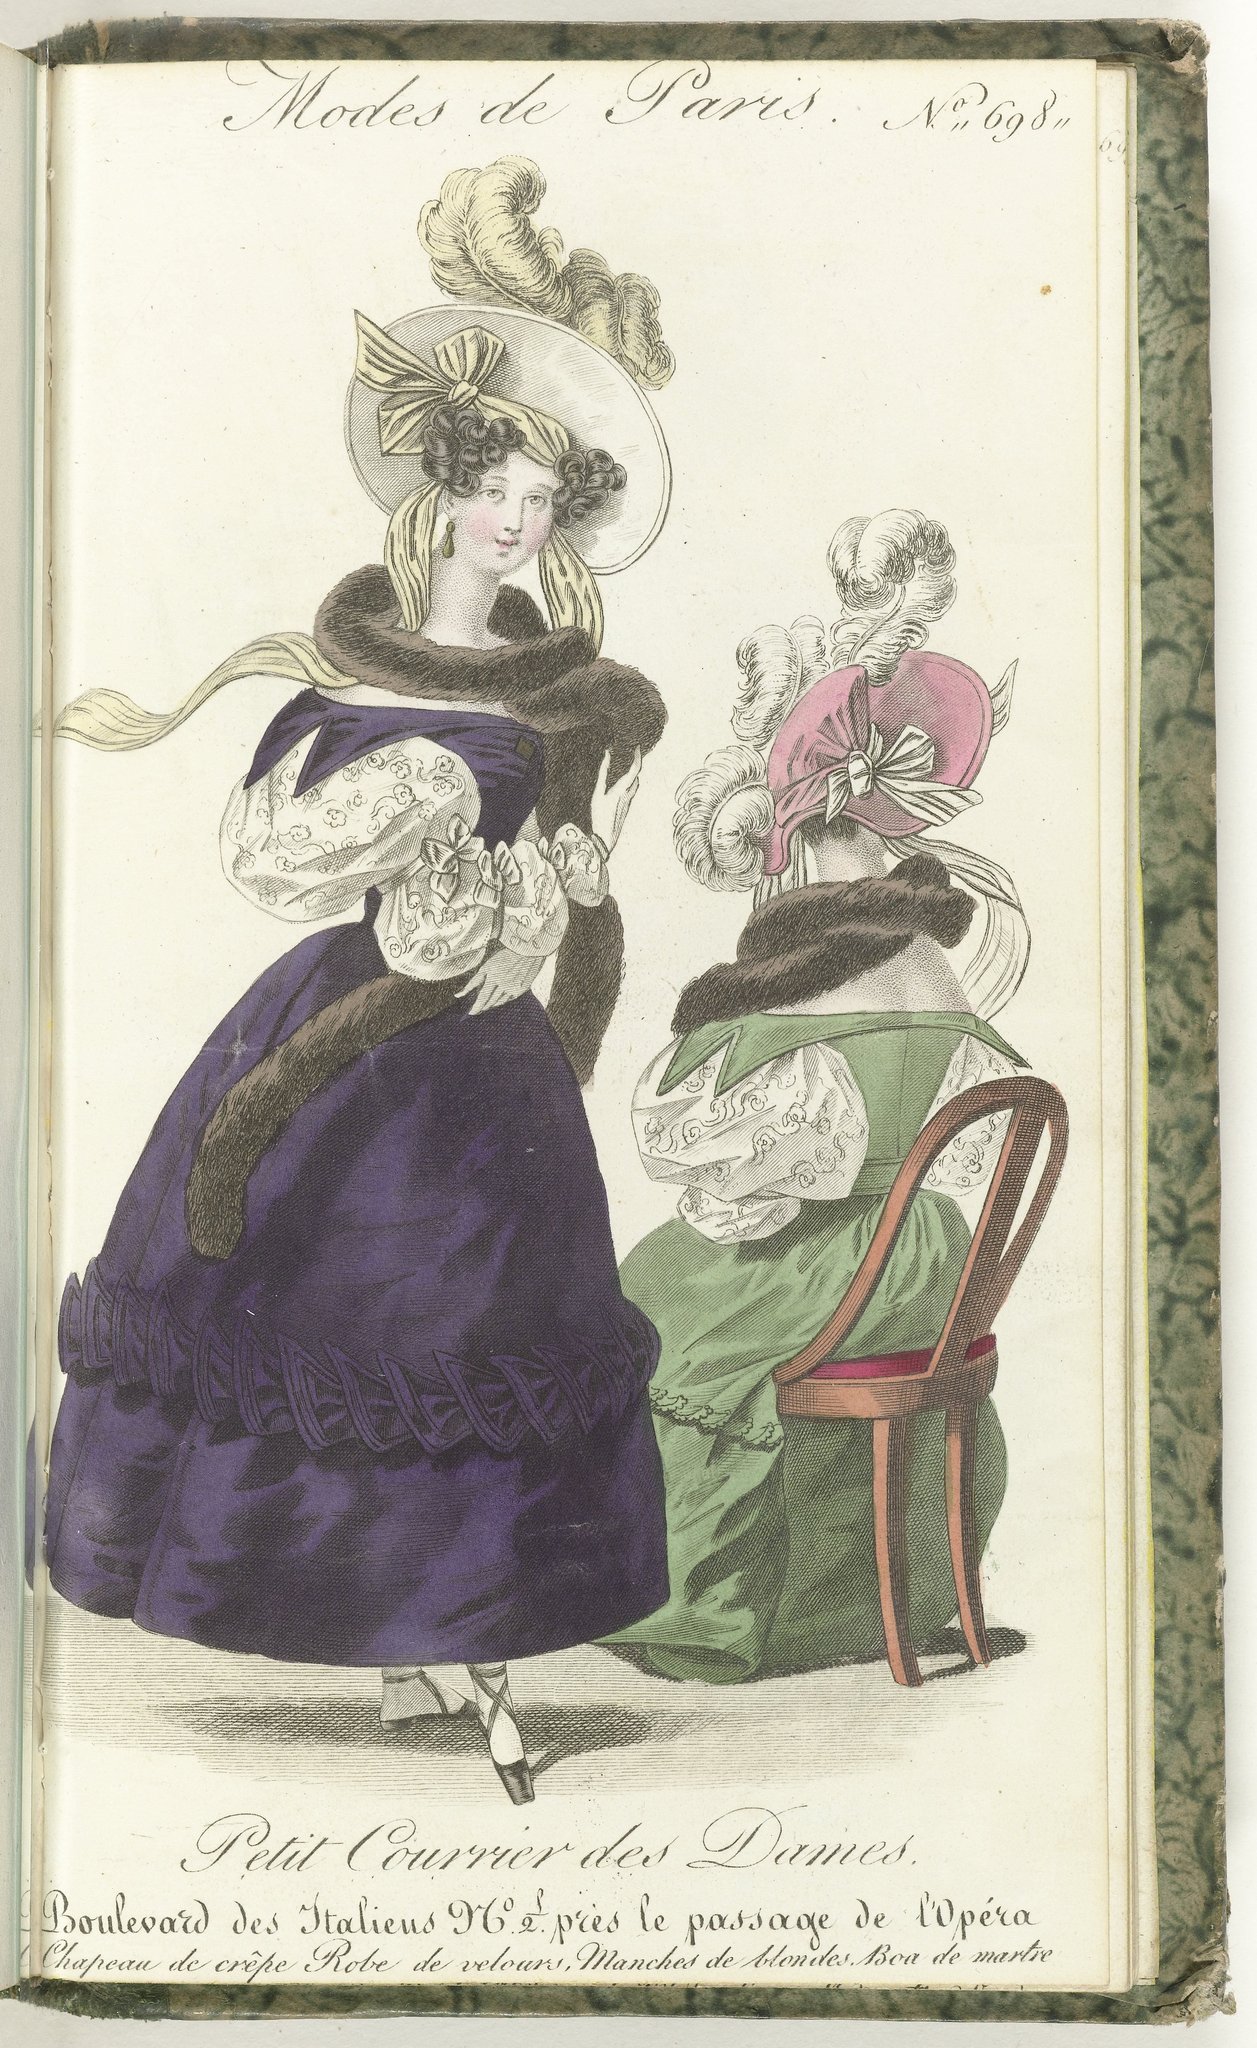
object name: fashion print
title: Petit Courrier des Dames, 31 janvier 1830, No. 698 : Chapeau de crêpe...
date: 1830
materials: paper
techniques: engraving, hand coloring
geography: paris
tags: clothing for the upper part of the body (boa) (+ women's clothes), clothing for the upper part of the body (boa) (+ fur used for clothes), fashion plates, head-gear: hat (+ women's clothes), dress, gown (+ women's clothes)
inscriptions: title: ‘Modes de Paris.’, address: ‘Boulevard des Italiens No.2 près le passage de l'Opèra.’, caption: ‘Chapeau de crêpe Robe de velours. Manches de blonde. Boa de martre’, title: ‘Petit Courrier des Dames.’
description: Staande vrouw gekleed in een japon van velours met mamelukkenmouwen van 'blonde' (kloskant). Hoed van crêpe. Om de hals een boa van marterbont. Zittende figuur, op de rug gezien, in eenzelfde japon. Prent uit het modetijdschrift Petit Courrier des Dames (1821-1868). Ingebonden (met enkele pag. Le Journal des Dames et des Modes). 15 Januari 1827 t/m 20 maart 1830. Incompleet.